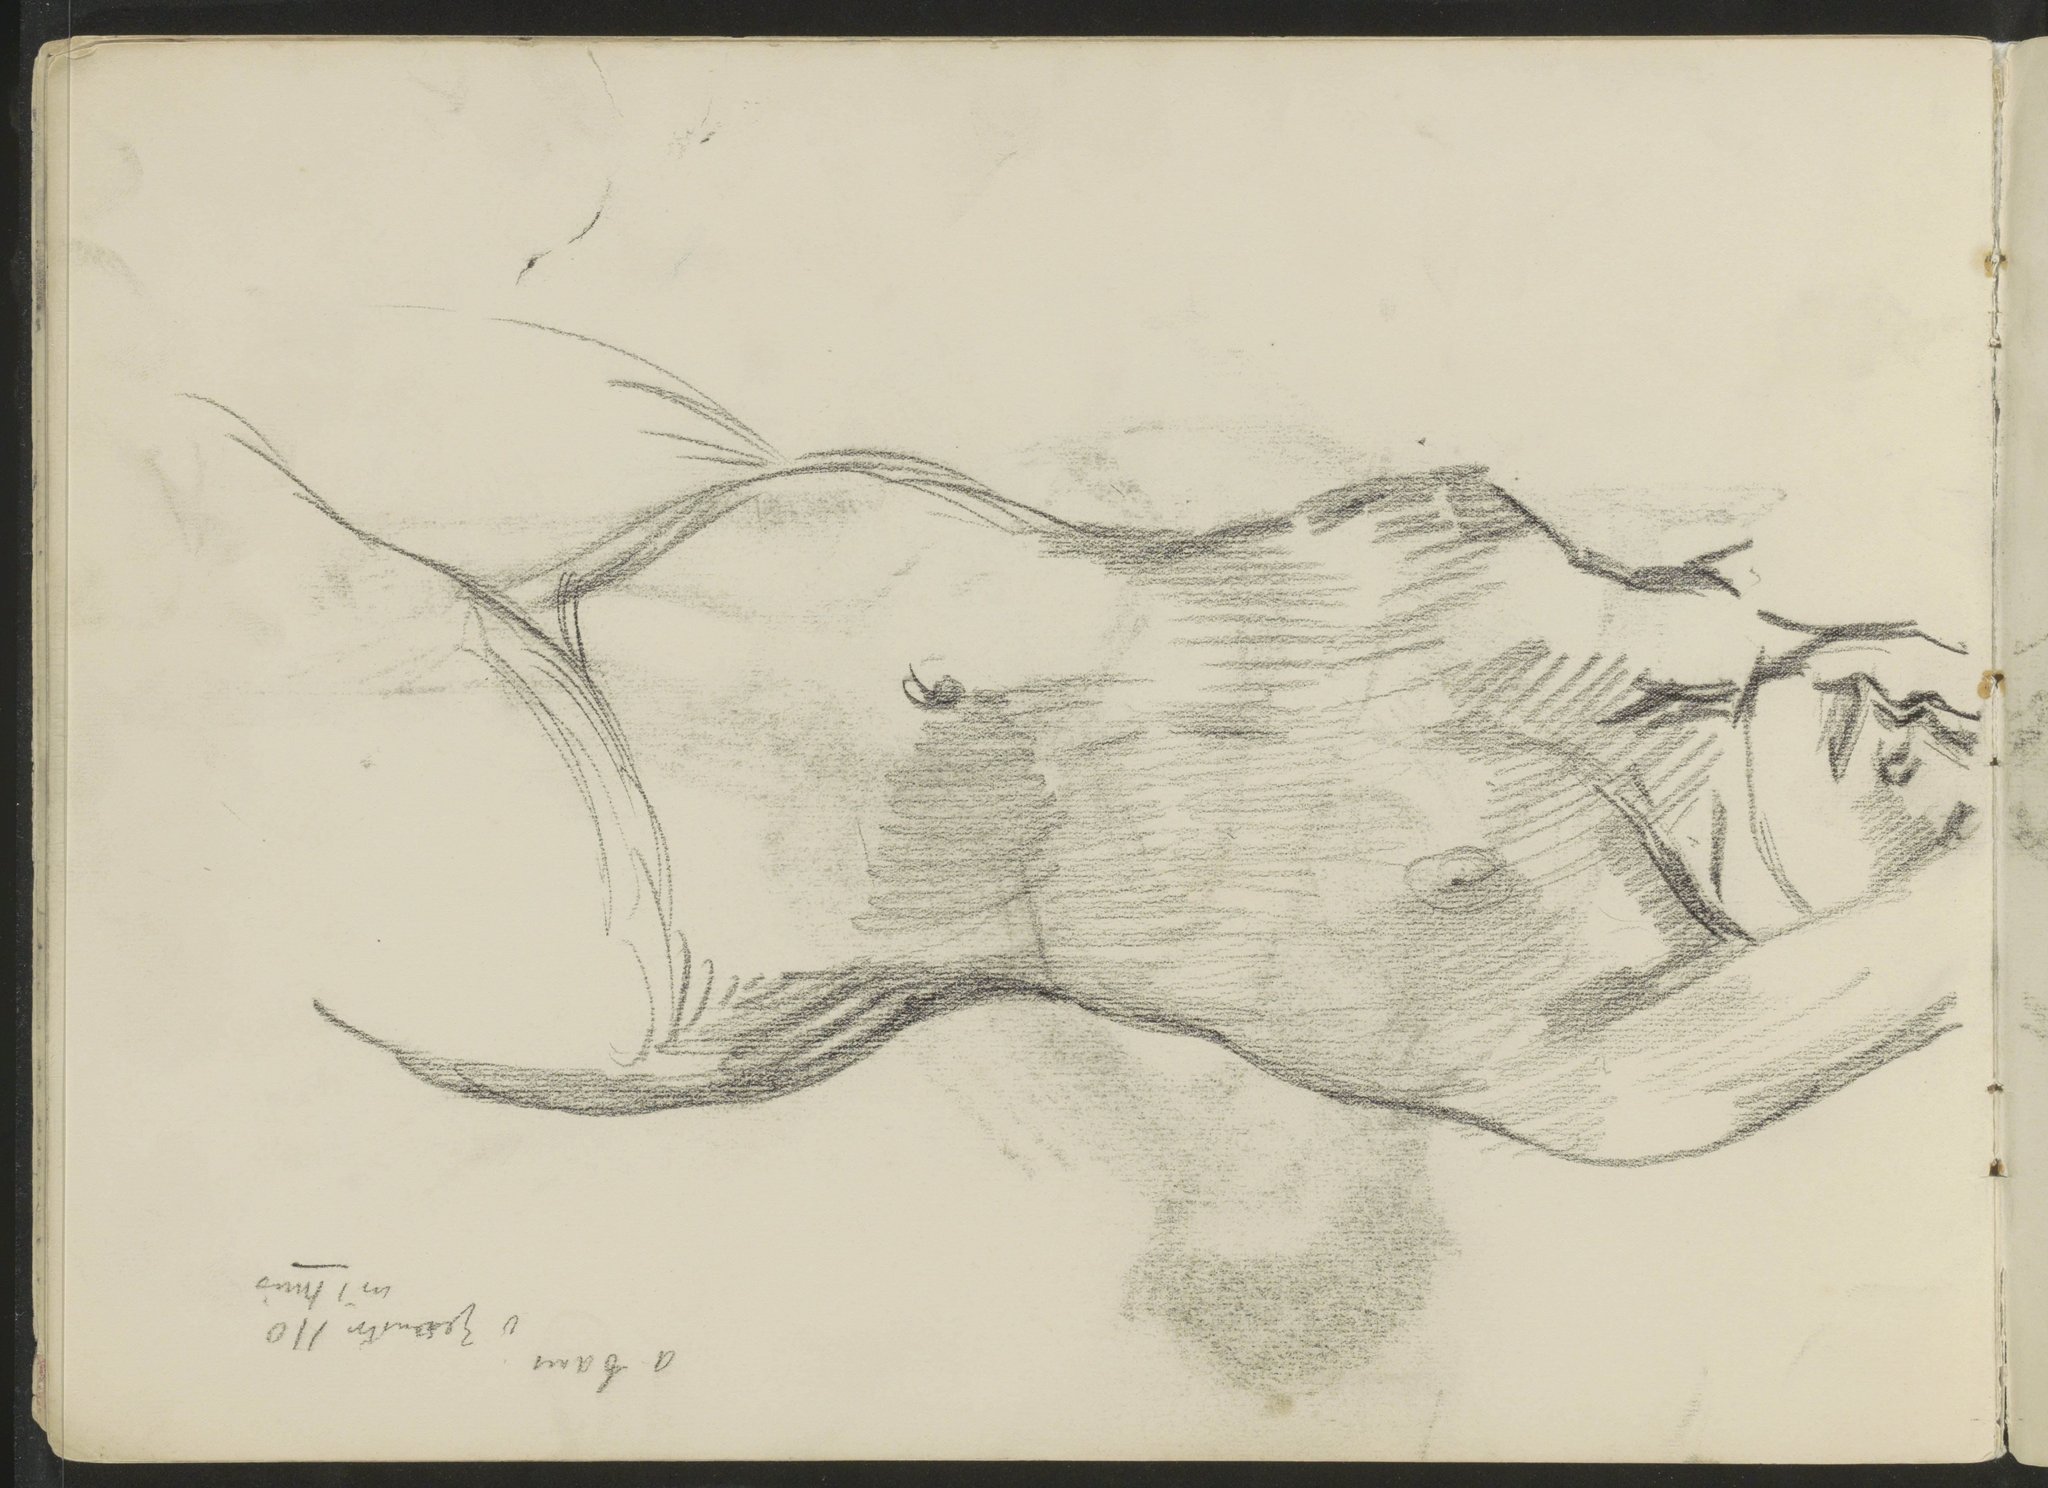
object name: sketchbook leaf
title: Vrouwelijk naakt met gestrekte armen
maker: isaac israels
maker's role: draughtsman, painter, print maker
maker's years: 1865-1934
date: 1886-1934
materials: chalk, paper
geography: amsterdam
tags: arm raised upward - aa - both arms or hands, the (nude) human figure; 'corpo humano' (ripa) - aa - female human figure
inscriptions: annotation: ‘a baus[?] / v Zedenstr[?] 110 / in 't huis’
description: Blad 10 verso uit schetsboek LXVII met 11 bladen.